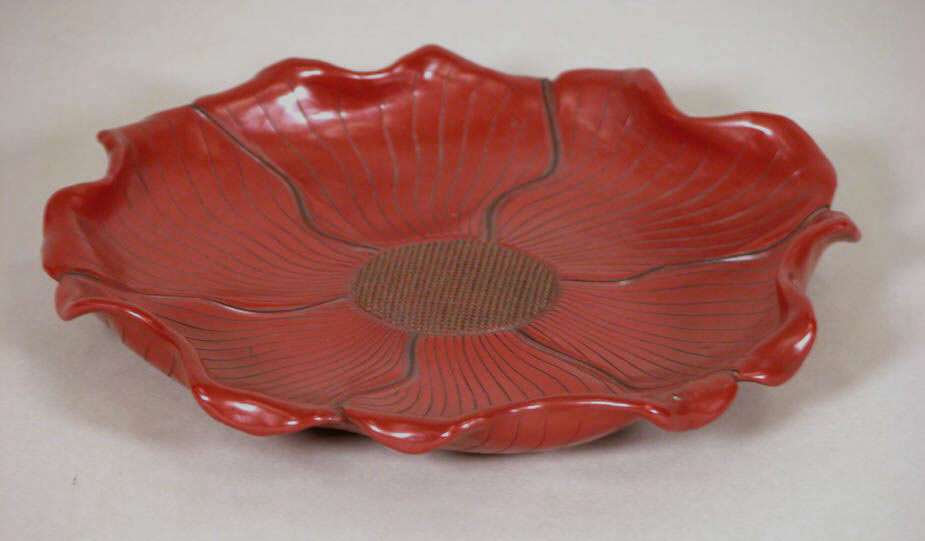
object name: tray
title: Tray in the shape of a peony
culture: chinese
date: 1801-1900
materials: lacquer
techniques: carving